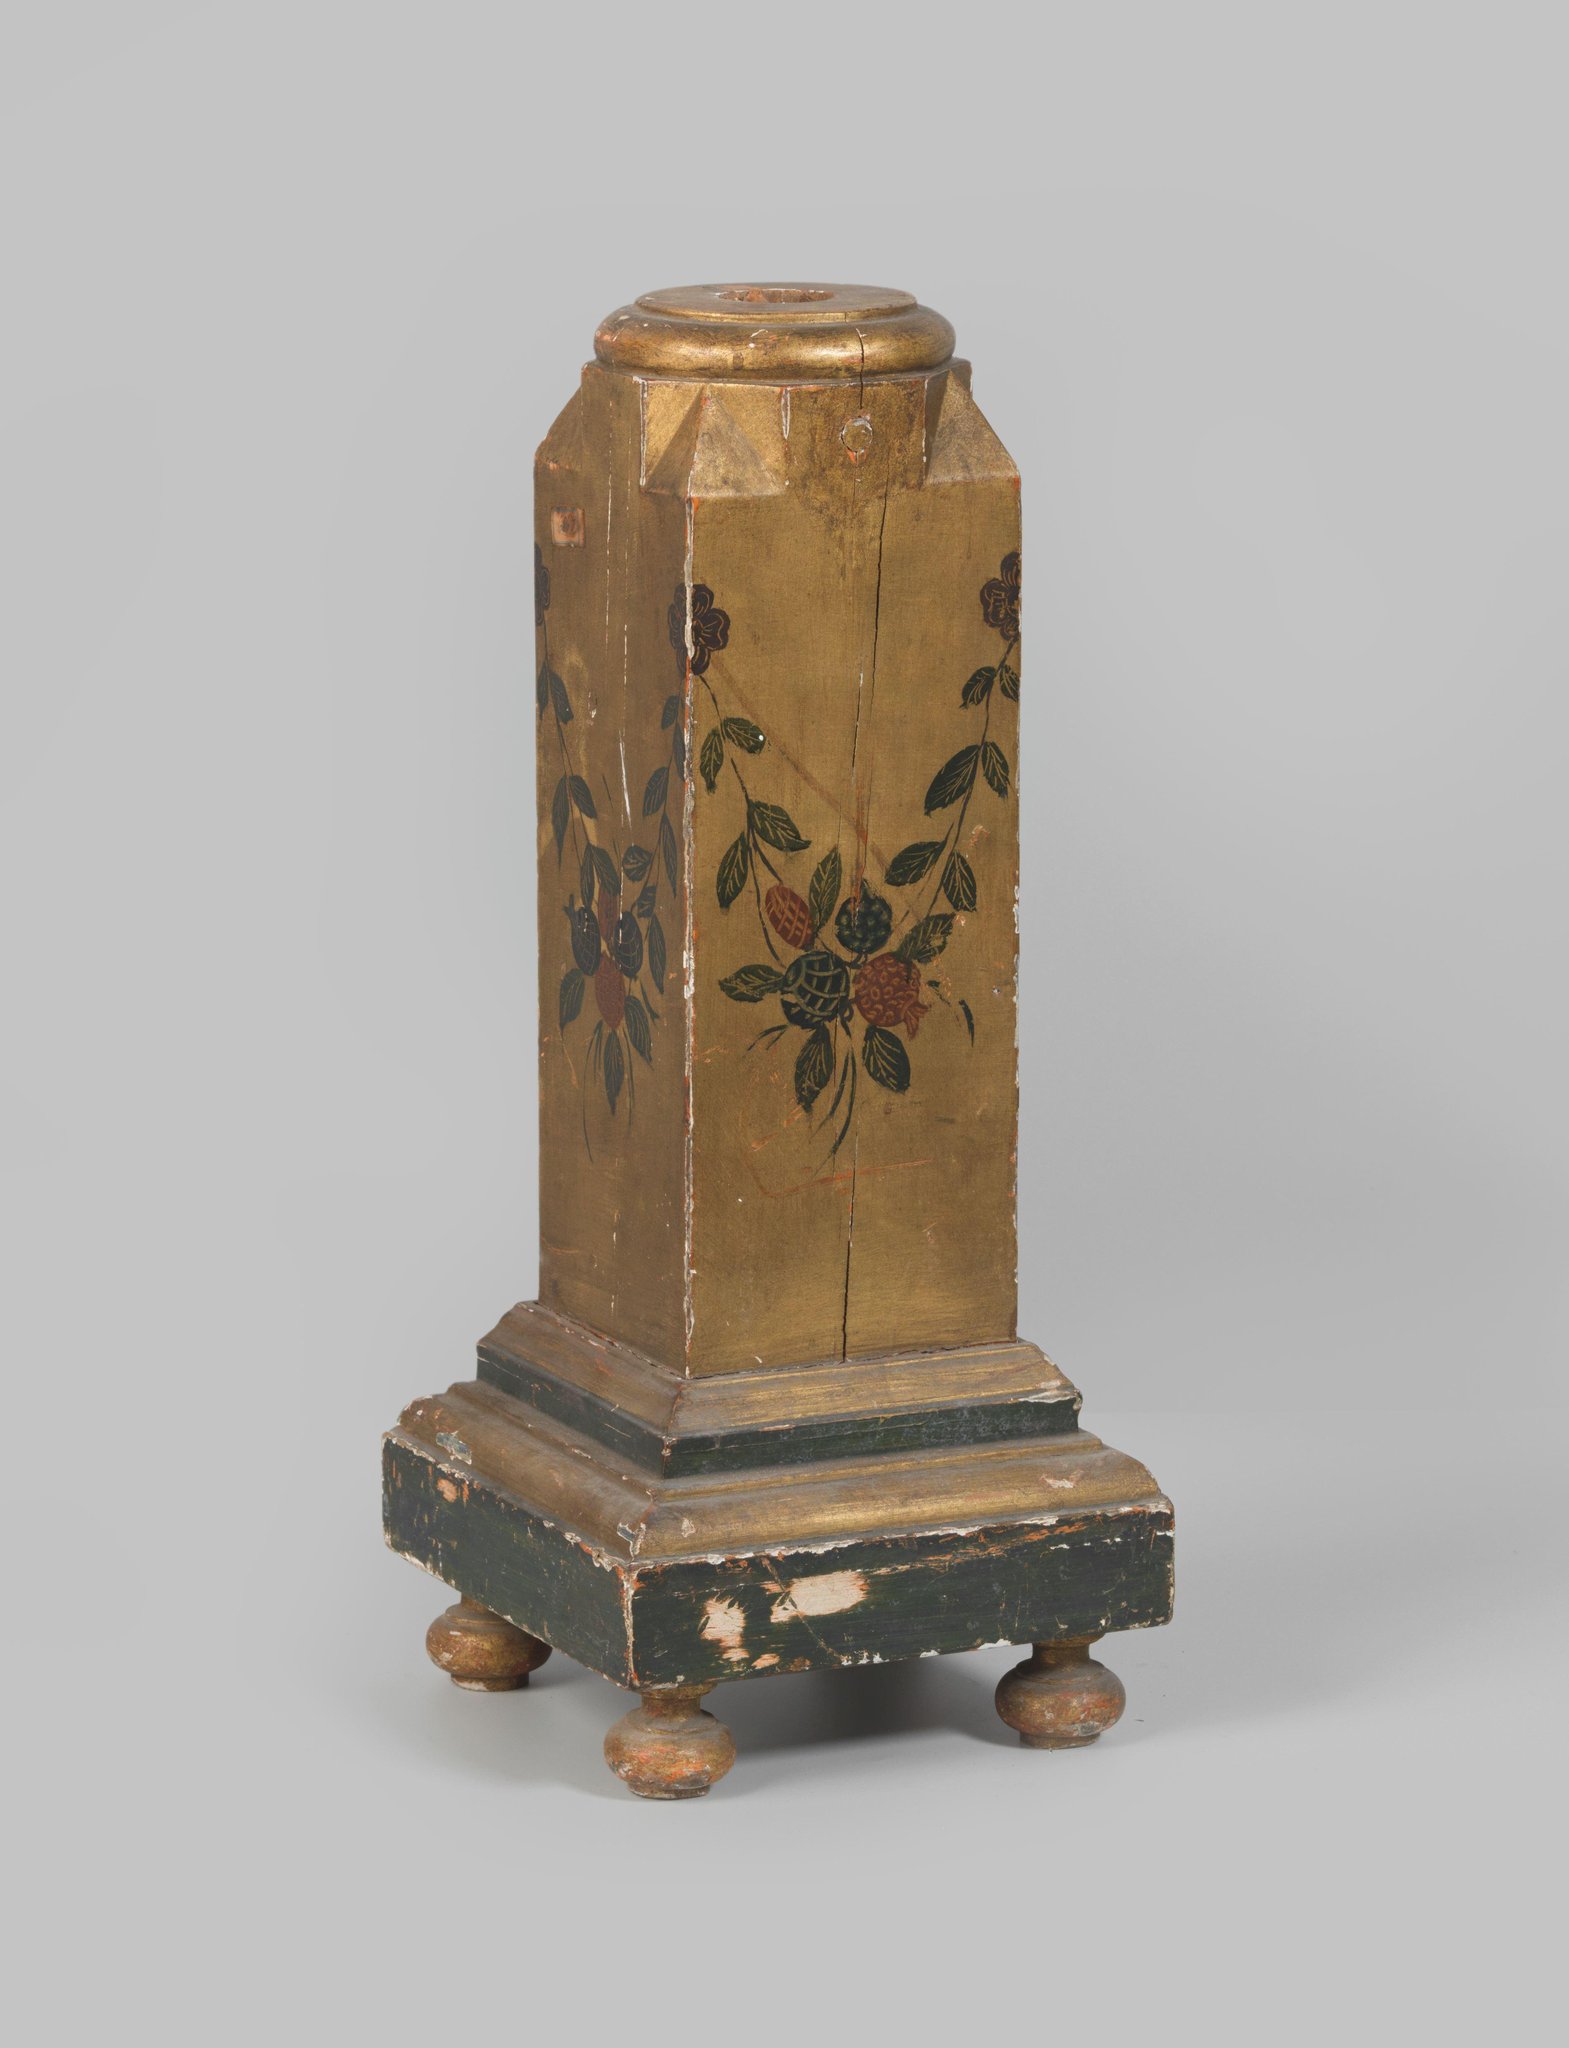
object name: column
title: Kolom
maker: Anonymous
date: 1500-1600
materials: wood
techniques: gilding, painted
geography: spain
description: Kolom op een vierkante basis van verguld, gedeeltelijk gepolychromeerd hout. De schacht is onderaan vierhoekig van vorm en met takken met bladeren beschilderd. Het ronde bovengedeelte van de schacht vertoont gestoken figuren met mascarons. Zie tevens: BK-16864-a.